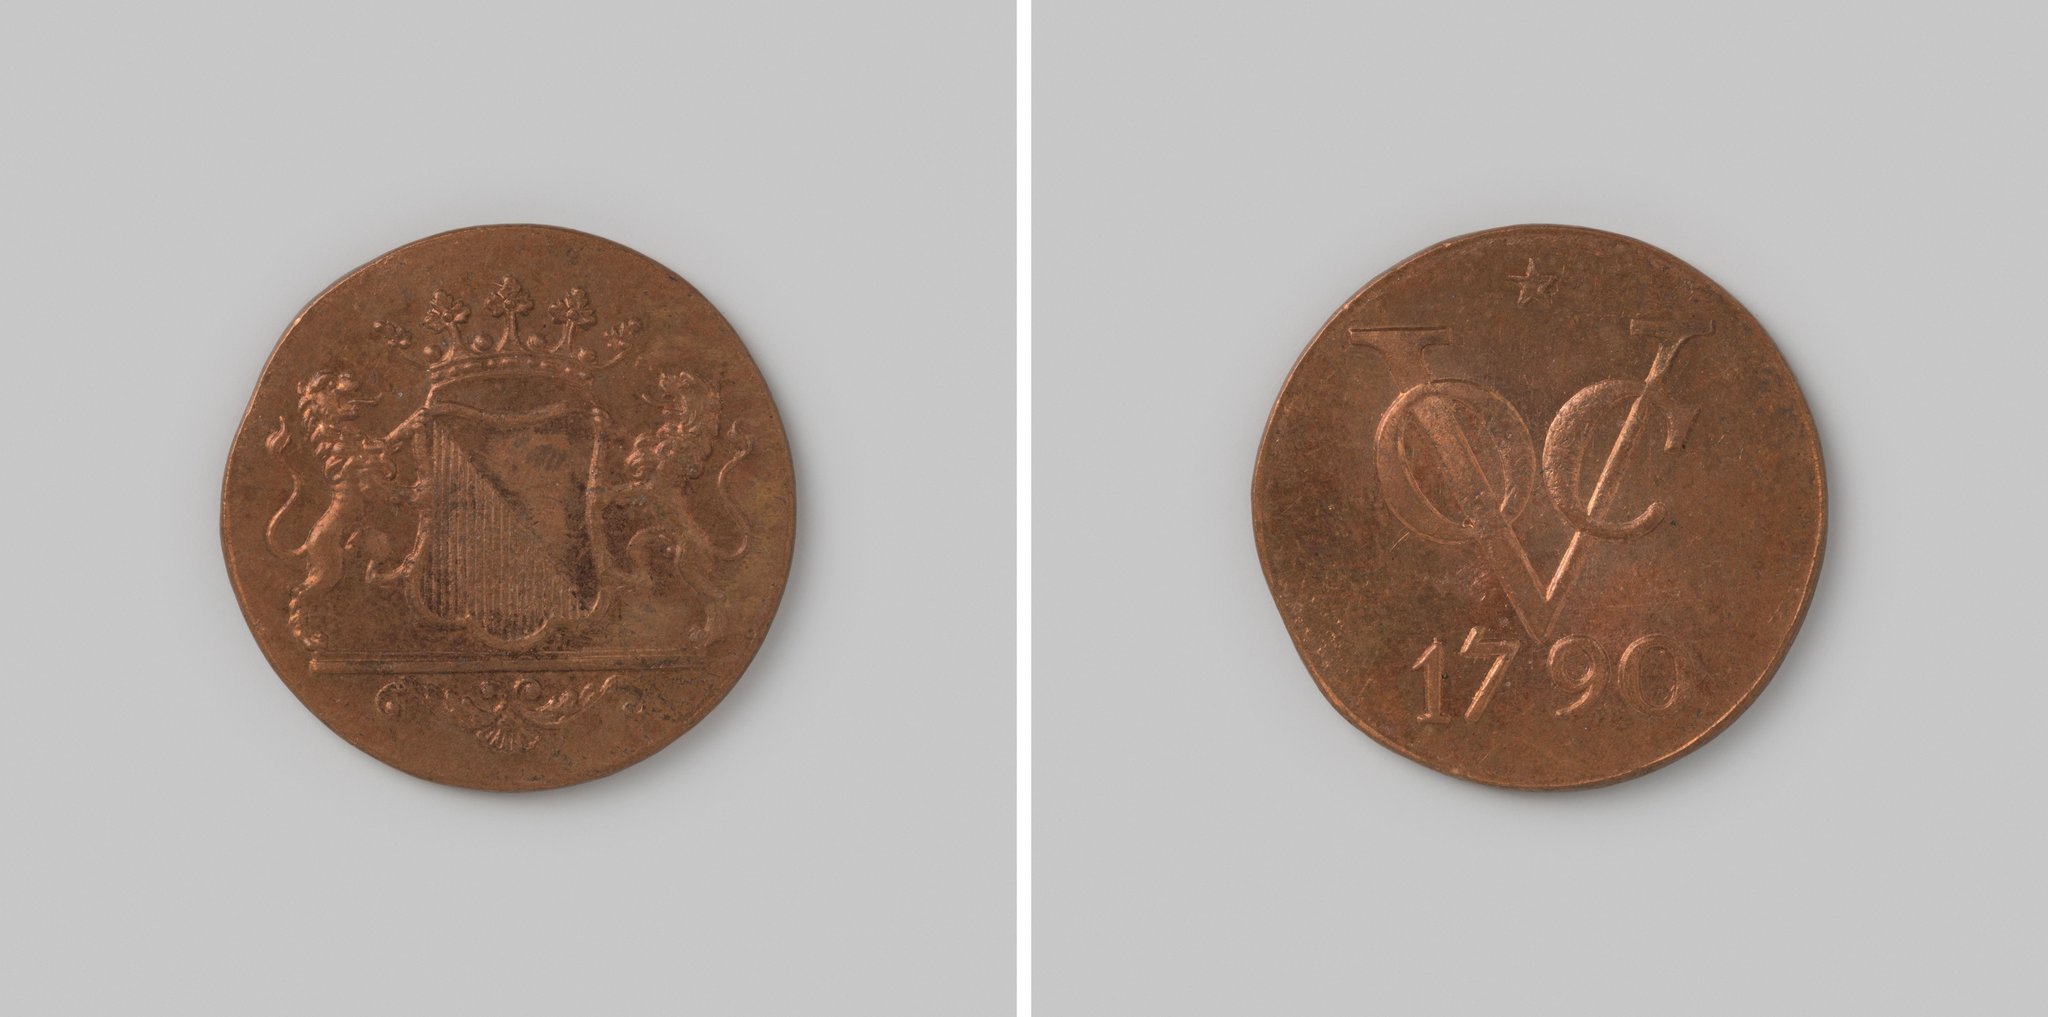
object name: coin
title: Dubbele duit van de VOC op naam van de stad Utrecht met jaartal 1790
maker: william ii of the netherlands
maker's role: koning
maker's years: 1792-1849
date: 1840-1843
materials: copper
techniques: striking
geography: surabaya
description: Koperen munt. Voorzijde: op balk, waaronder guirlande, staand, door twee leeuwen gehouden gekroond wapenschild van de stad Utrecht. Keerzijde: monogram van de VOC, waarboven muntteken ster en waaronder fictief jaartal 1790. Gladde rand.